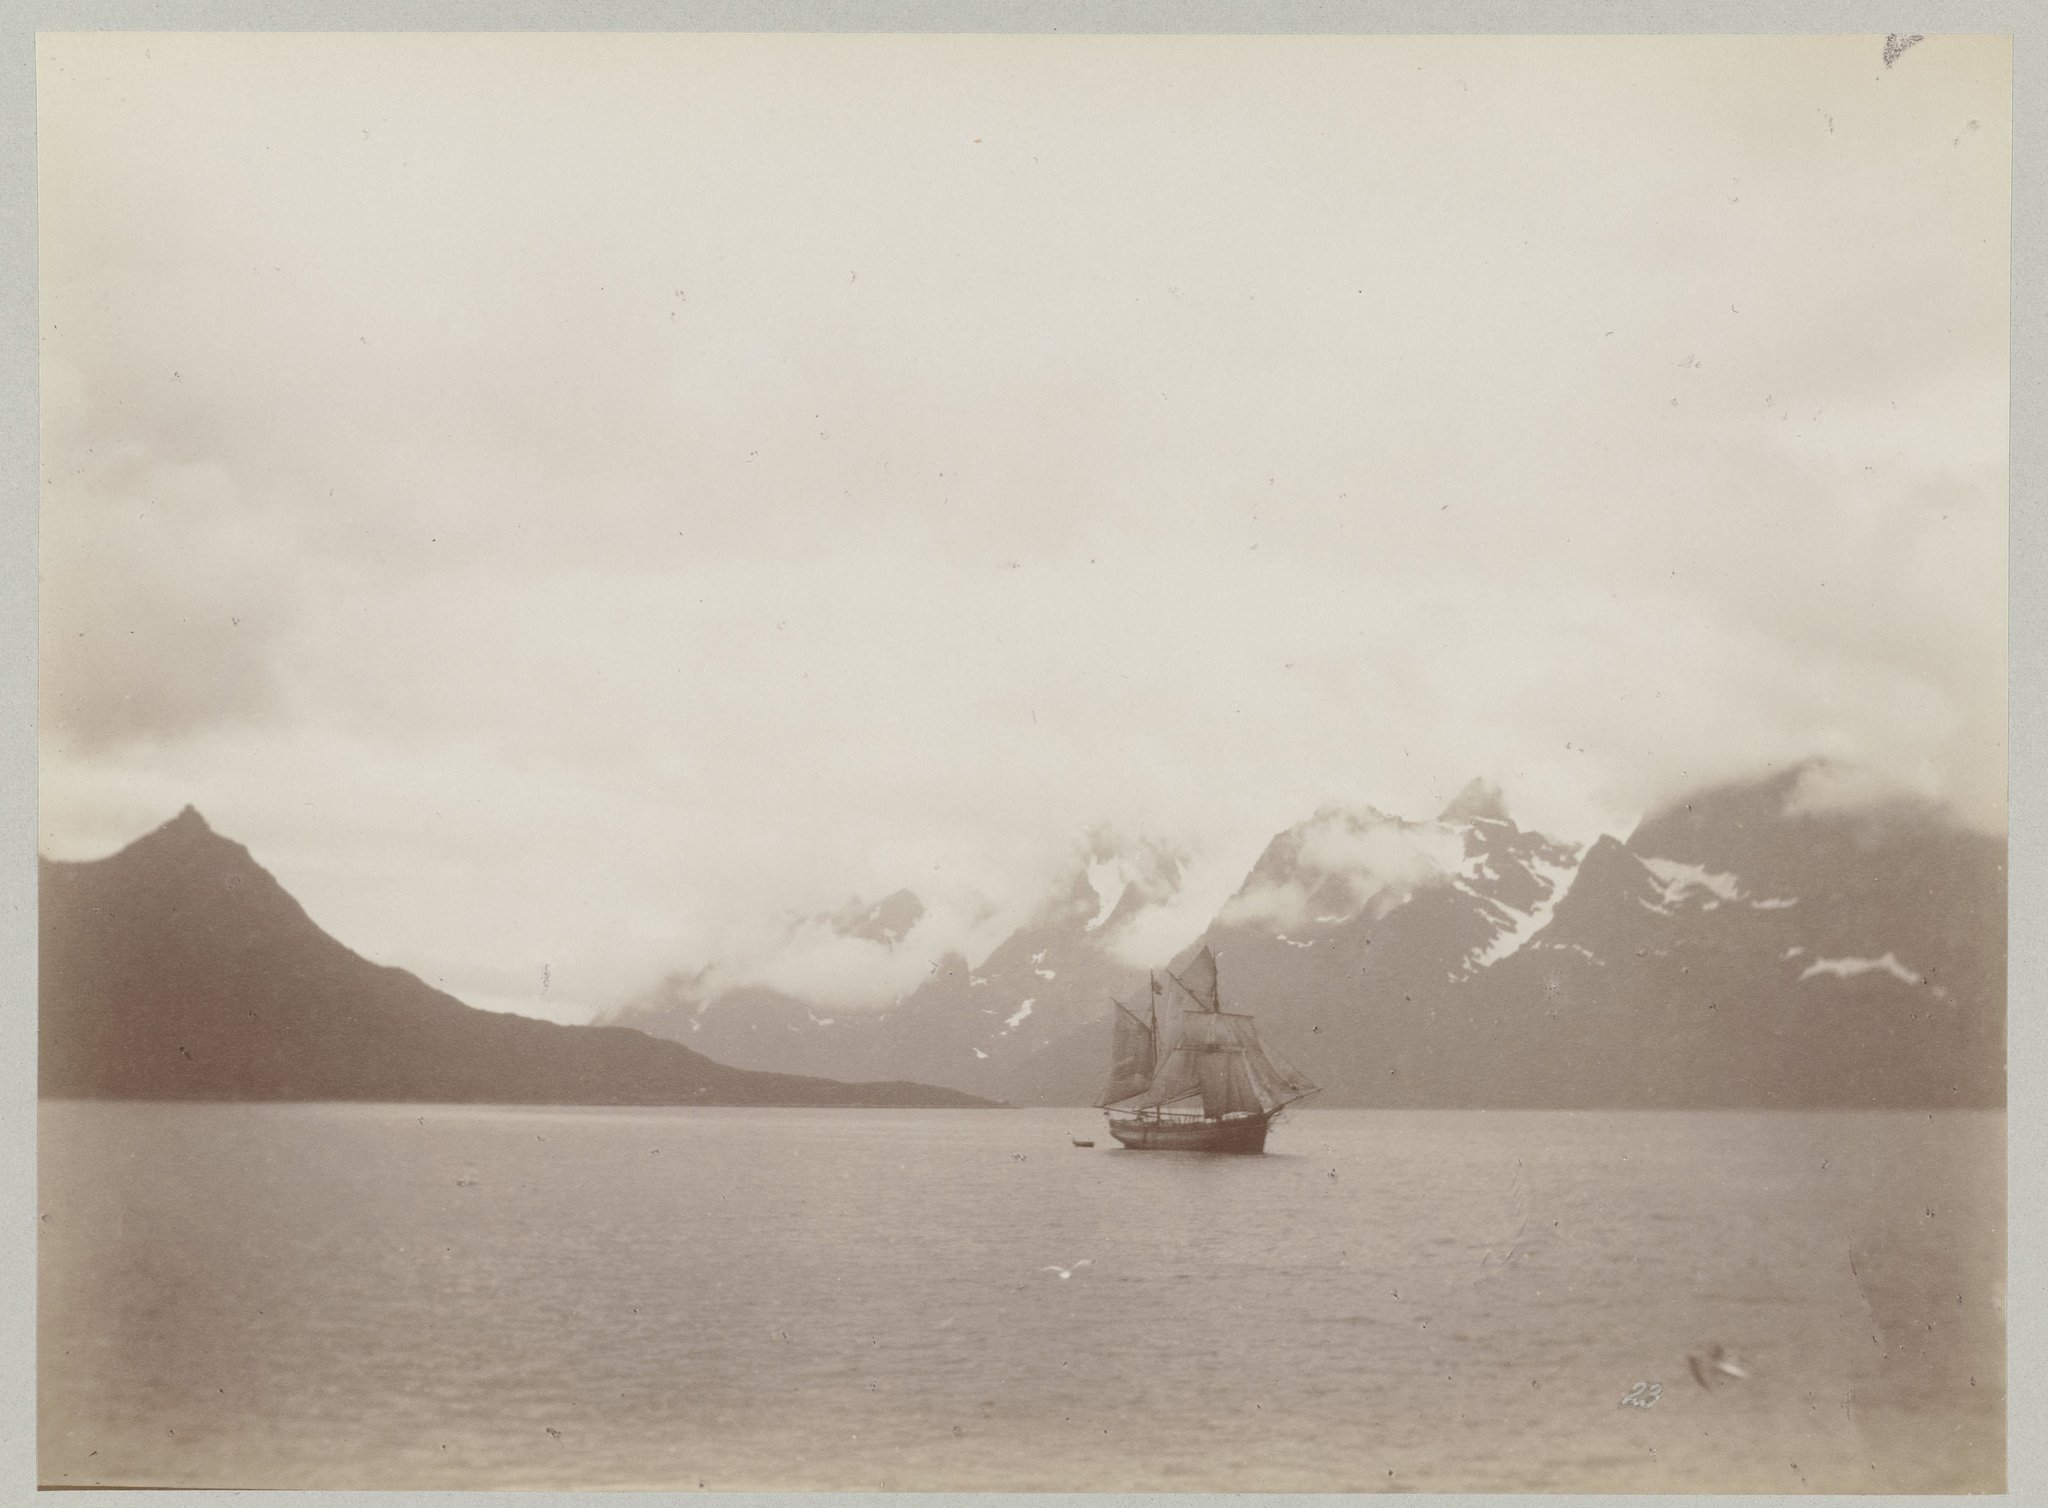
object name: photograph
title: Schip op zee tegen de achtergrond van besneeuwde bergtoppen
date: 1807-1889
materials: cardboard, paper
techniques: albumen print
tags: wilhelm ii (keizer van duitsland), norway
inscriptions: number: ‘34’, number: ‘23’